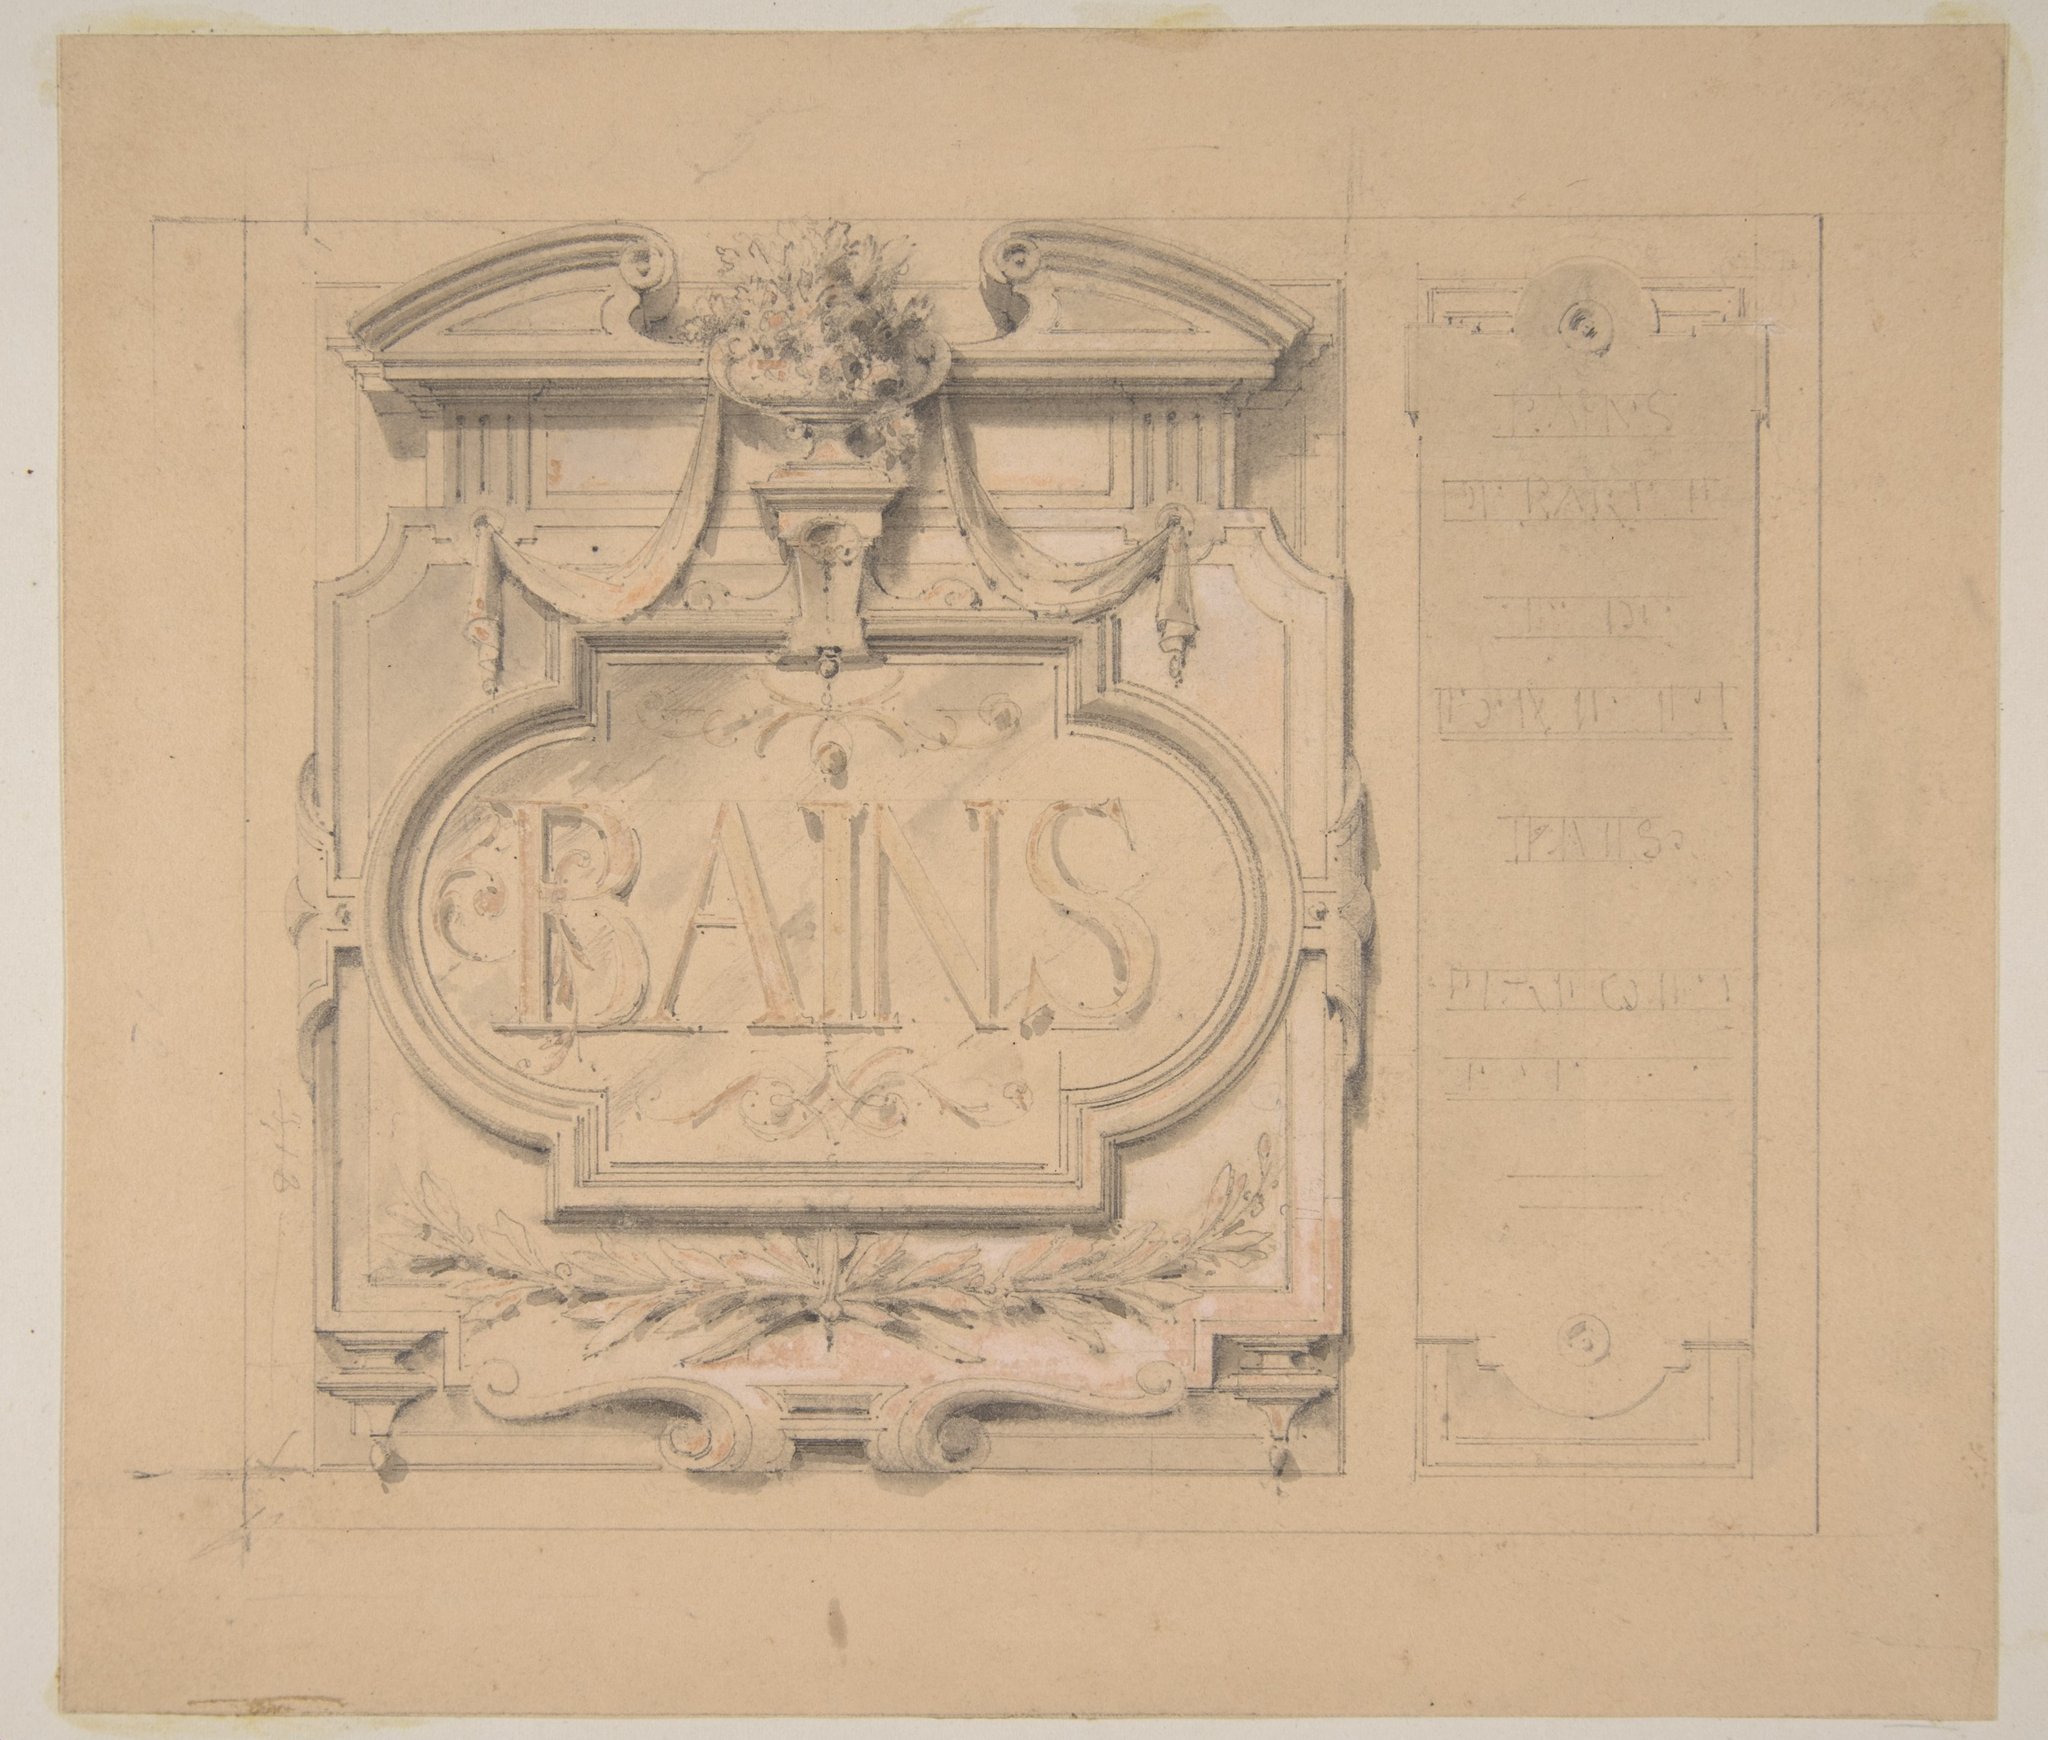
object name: drawing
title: Design for an ornamental plaque for a bath house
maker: jules-edmond-charles lachaise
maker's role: artist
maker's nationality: french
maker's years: 1897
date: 1830-1897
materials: graphite, watercolor, paper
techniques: wash